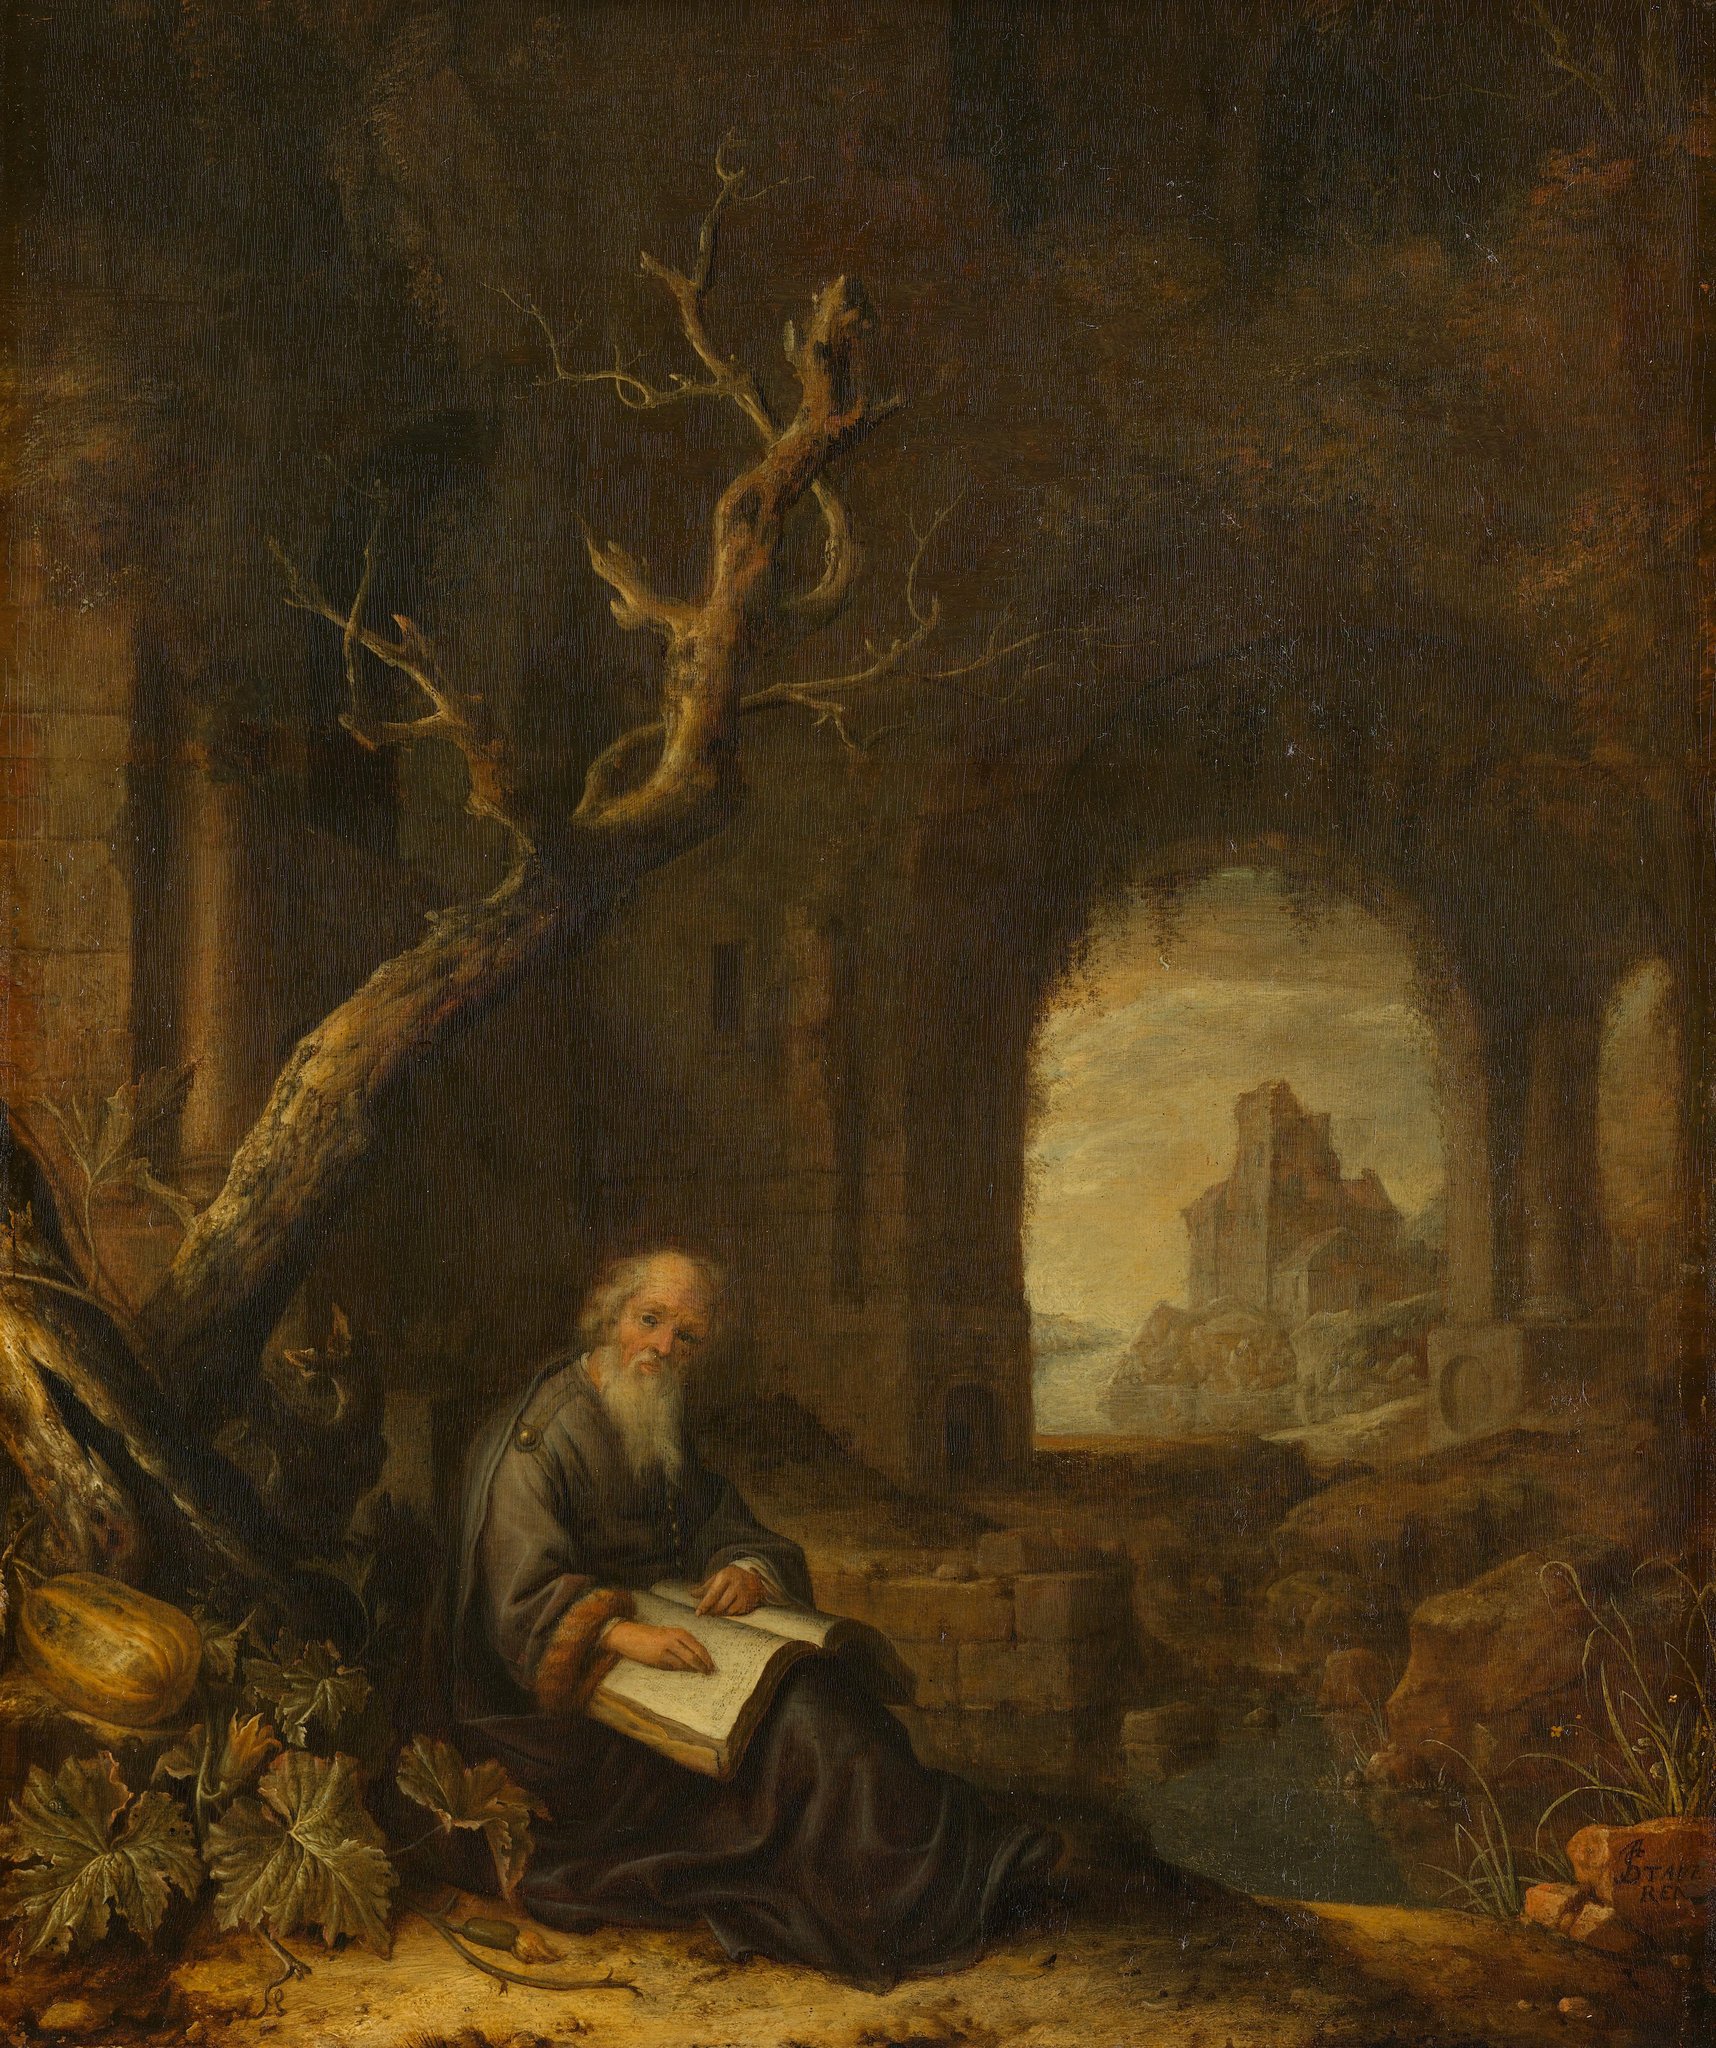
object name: painting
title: A Hermit in a Ruin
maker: jan adriaensz. van staveren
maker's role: painter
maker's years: 1613-1669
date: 1650-1668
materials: oil, panel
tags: anchorite, hermit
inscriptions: signature: ‘JAStaveren’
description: Een kluizenaar in een ruïne. Een oude man zit met een boek op schoot onder een dorre boom. Aan de voet van de boom groeit een kalebas of pompoen.